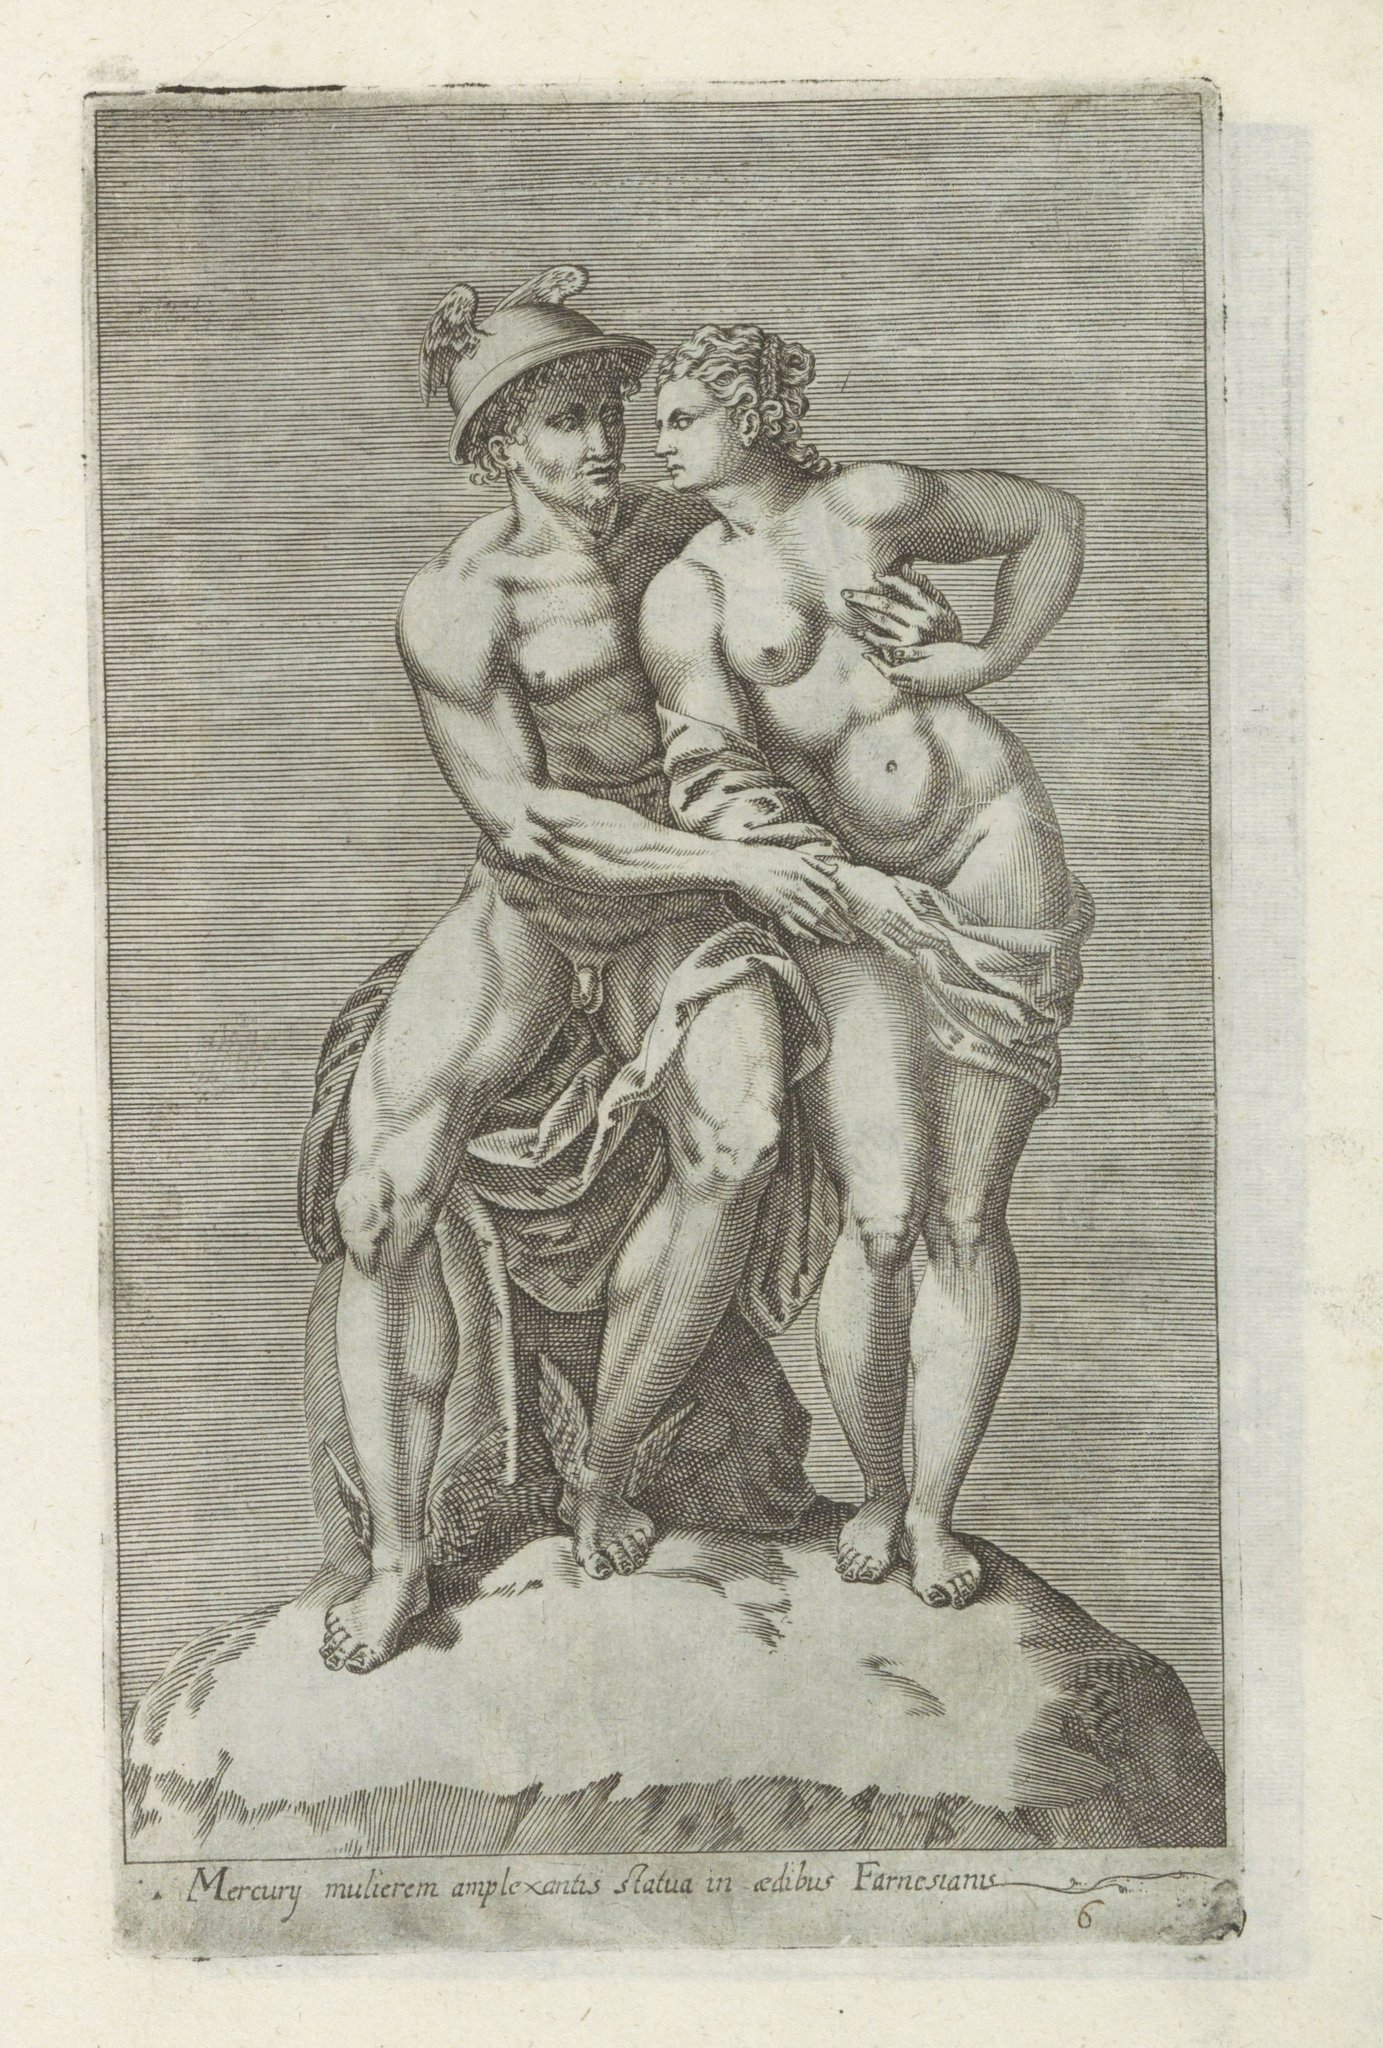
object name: album leaf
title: Mercury mulierem amplexantis statua in aedibus Farnesianis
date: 1584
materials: paper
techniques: engraving, intaglio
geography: italy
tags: (story of) mercury (hermes), piece of sculpture, reproduction of a piece of sculpture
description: Deze prent maakt deel uit van een set van 79 prenten (+ titelprent) met voorstellingen van antieke sculpturen in Rome.